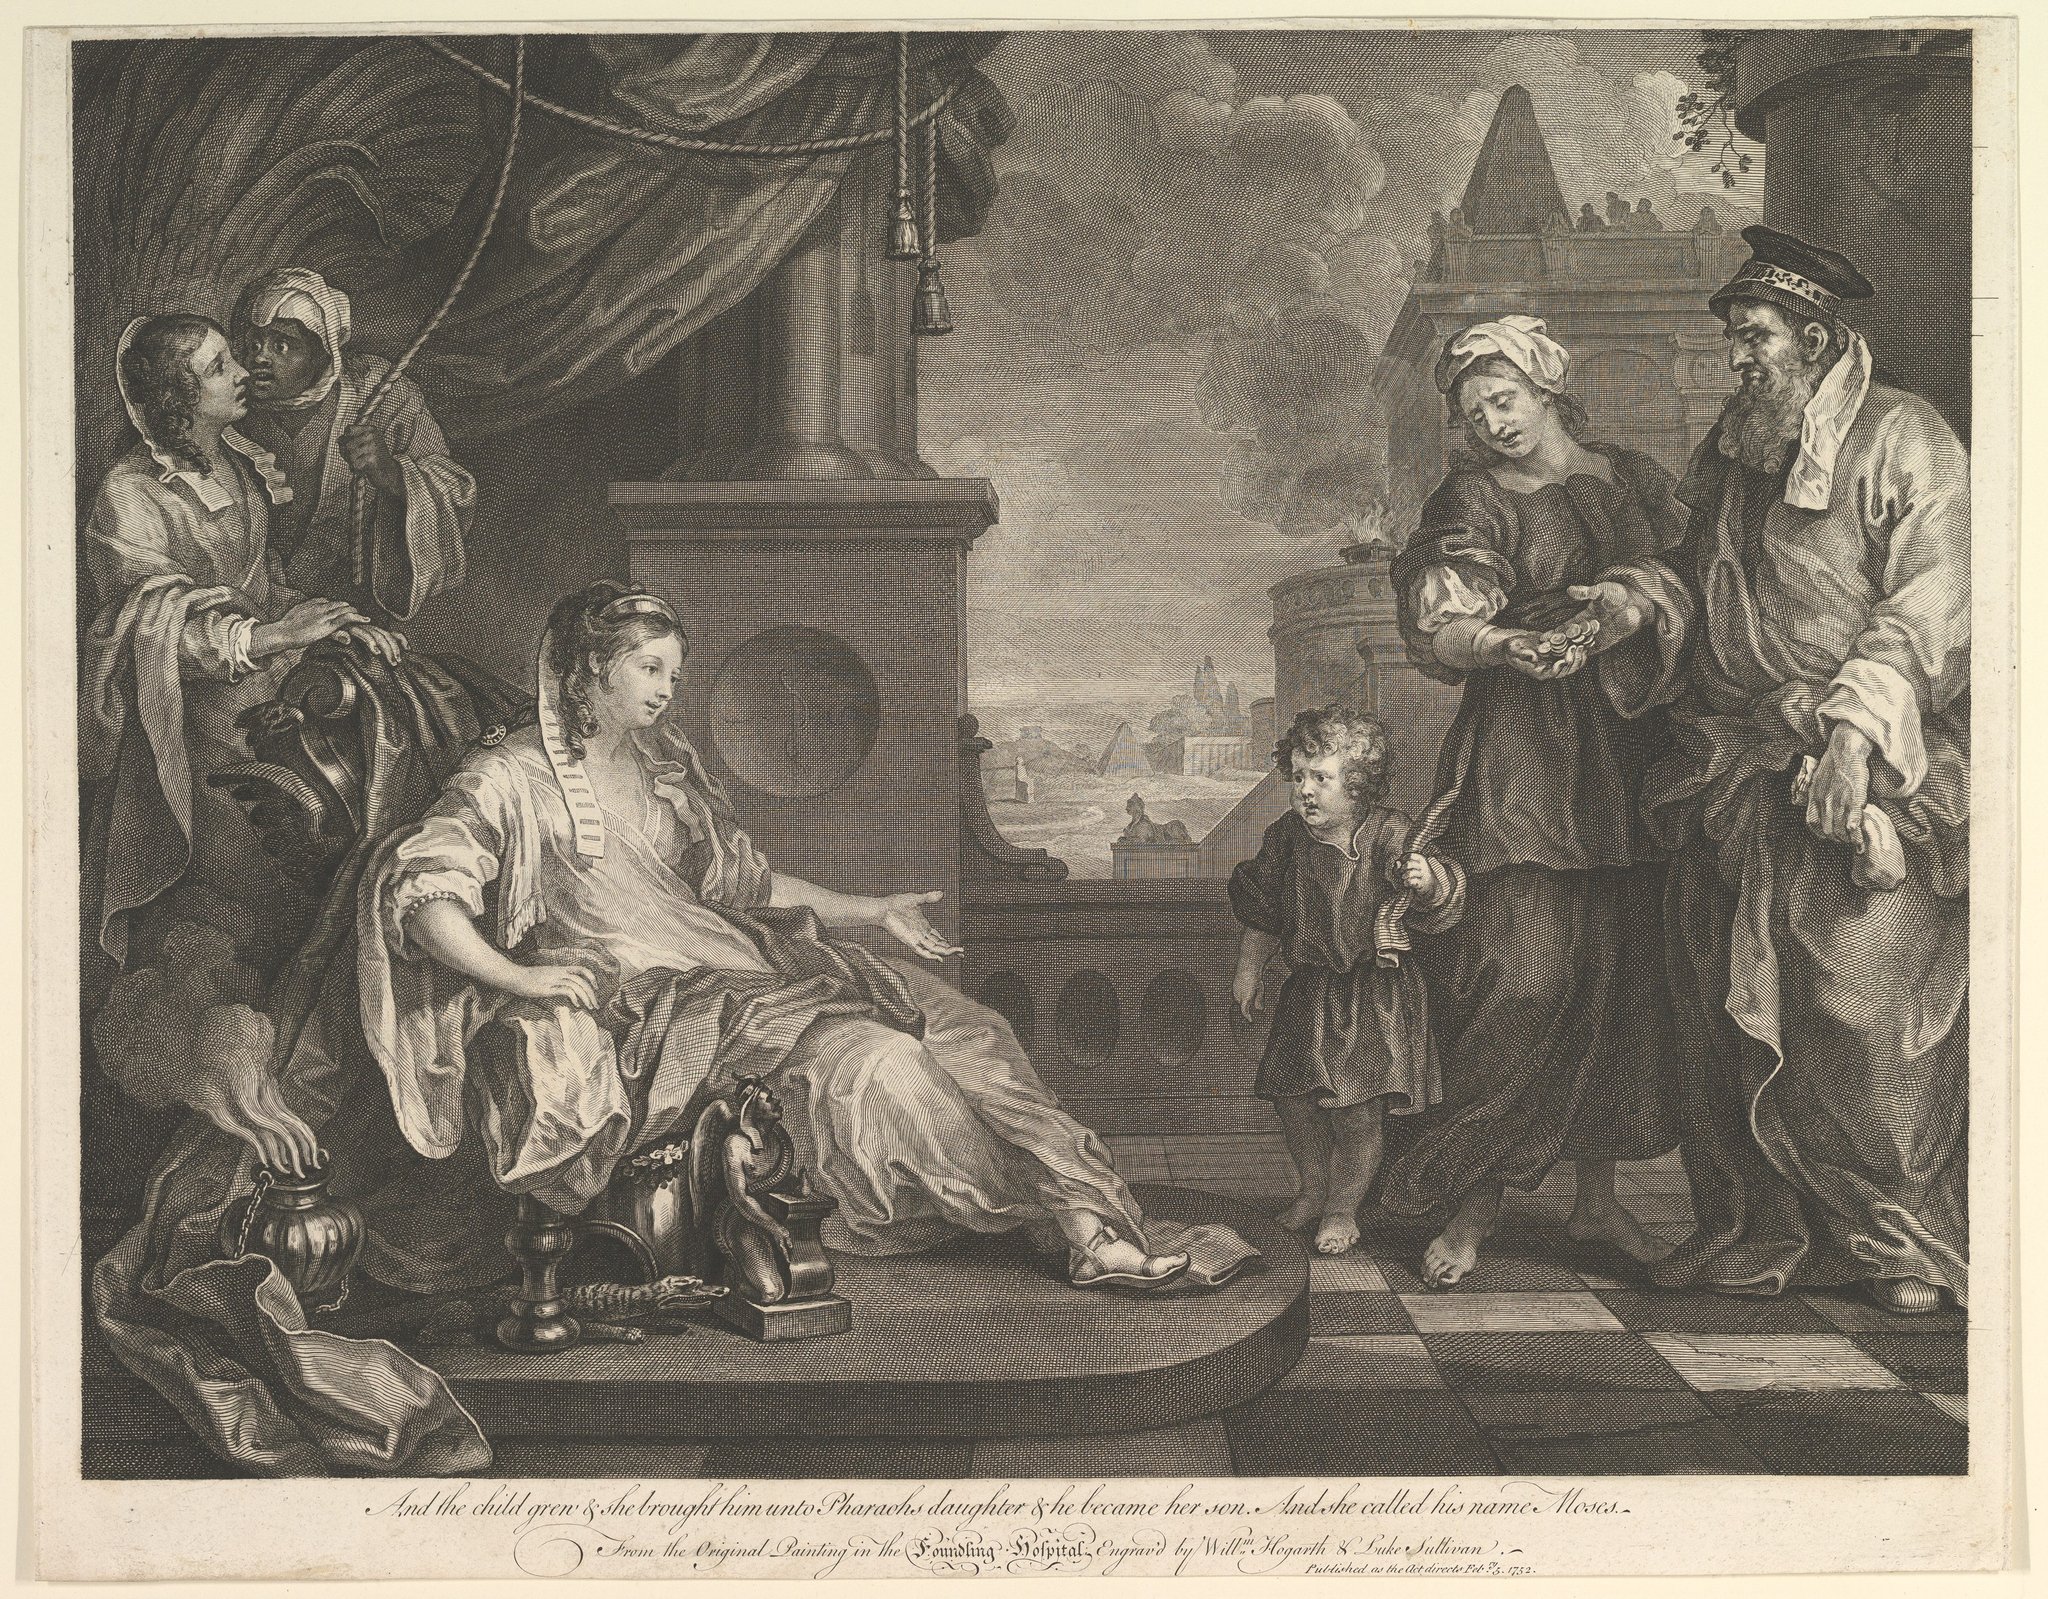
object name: print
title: Moses Brought to Pharaoh's Daughter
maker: william hogarth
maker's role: artist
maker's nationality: british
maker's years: 1697-1764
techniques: engraving, etching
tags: girls,men,women,moses